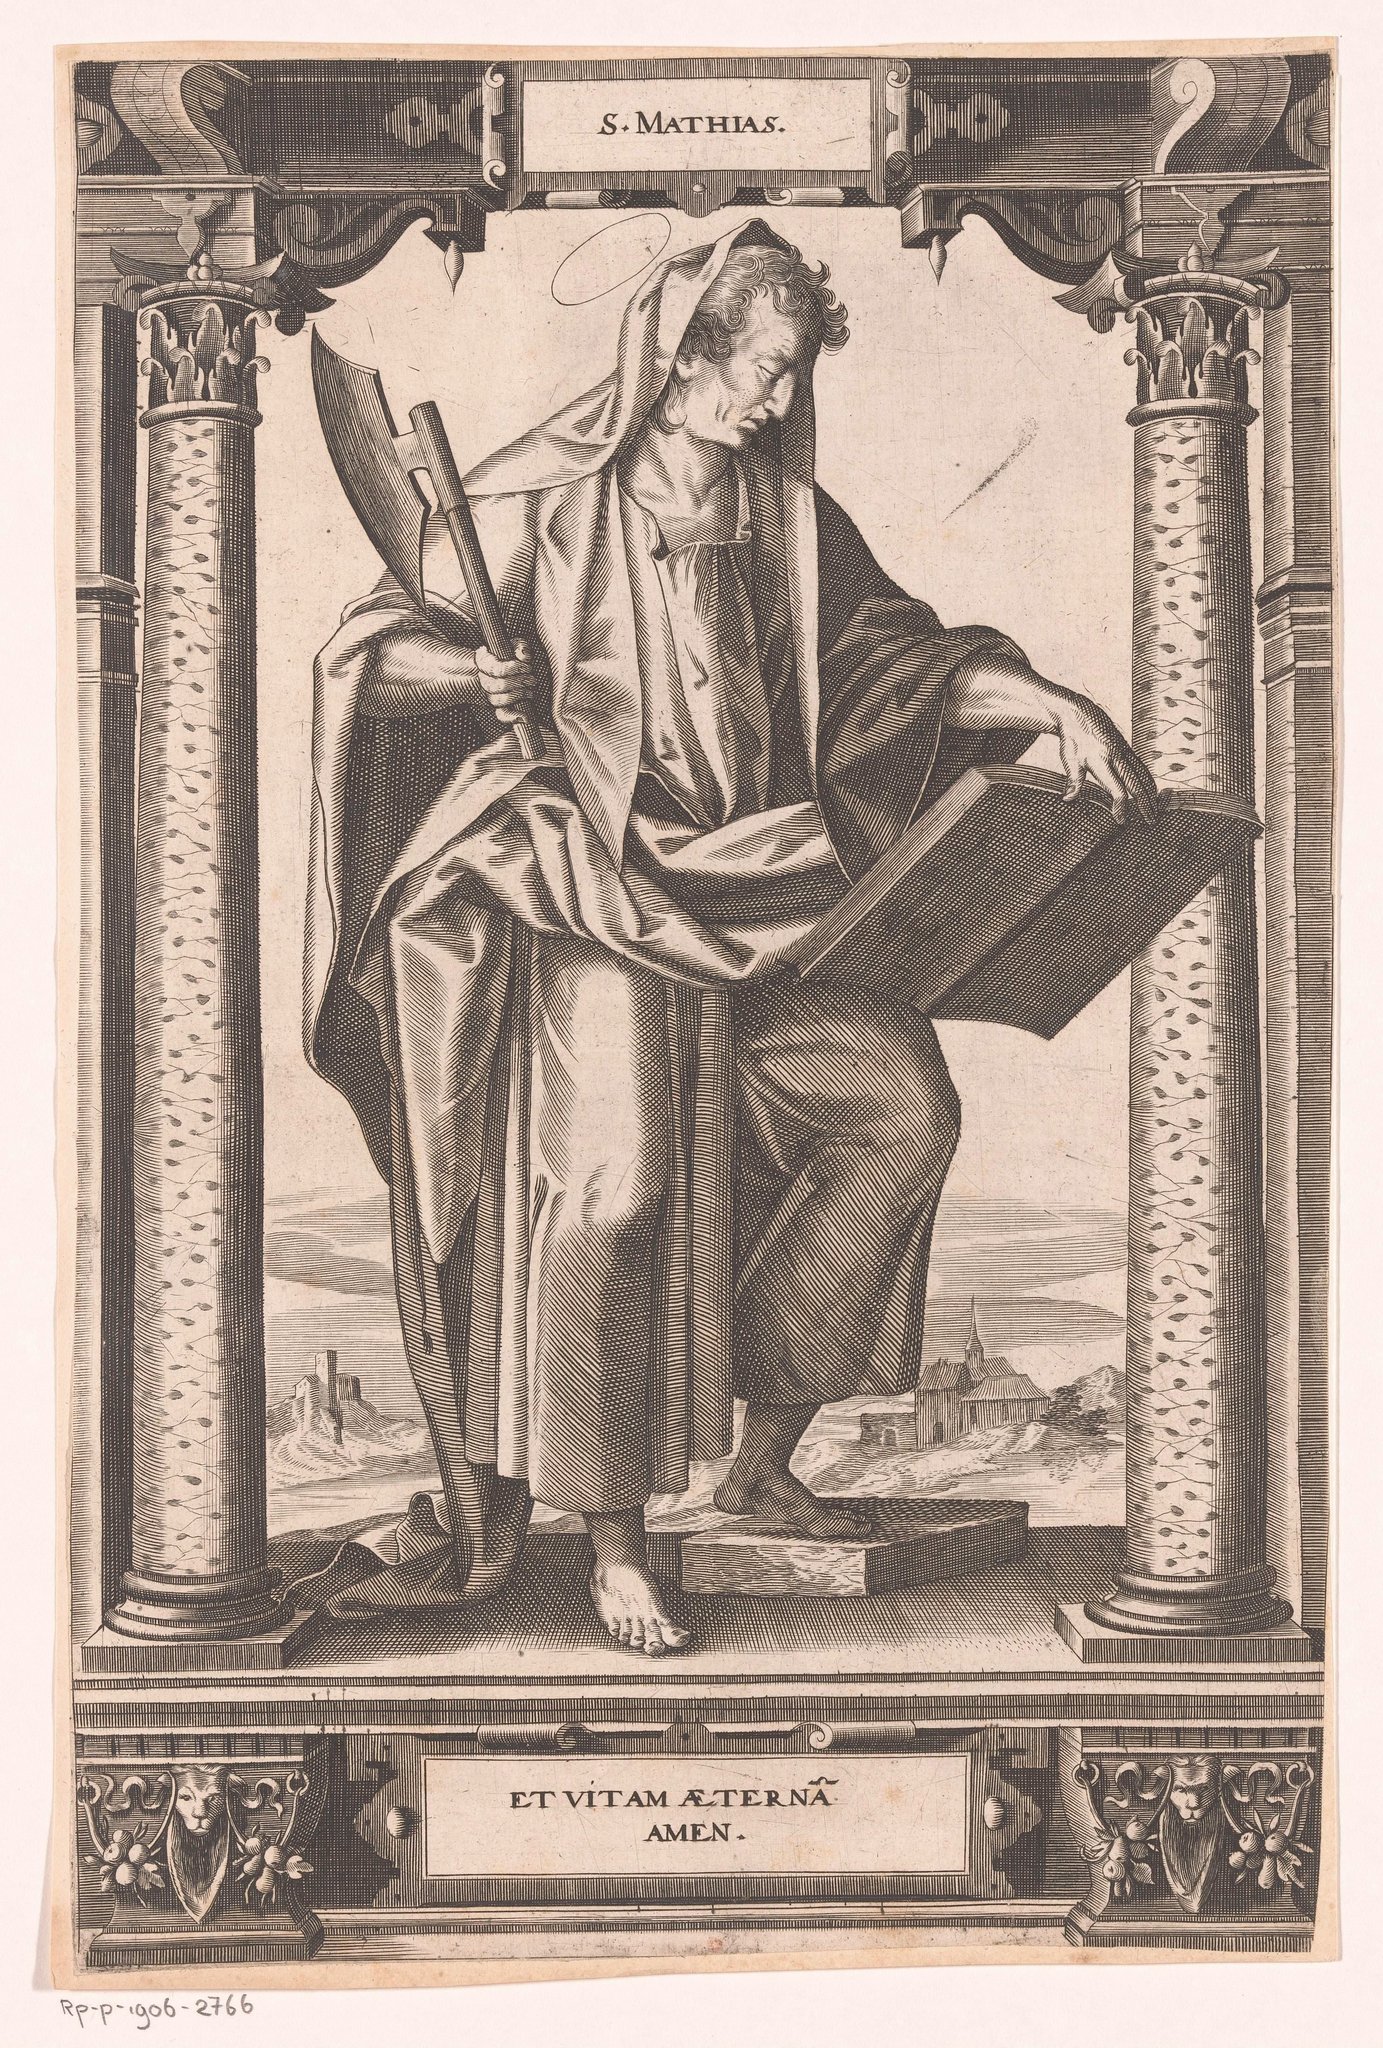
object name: print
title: S. Mathias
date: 1614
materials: paper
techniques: engraving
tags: the apostle and martyr matthias; possible attributes: axe, book, cross, halberd, scroll, sword - portrait of male saint, architectural detail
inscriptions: collector's mark: Lugt 2228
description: Onderdeel van een serie van veertien prenten. Vervaardigingsdetails vermeld op de eerste prent.